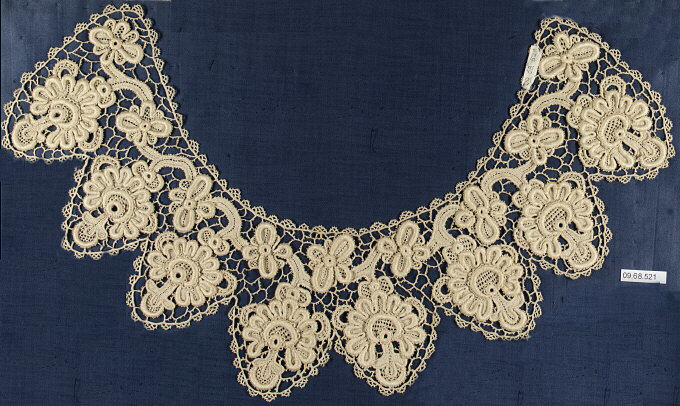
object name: collar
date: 1801-1900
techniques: lace